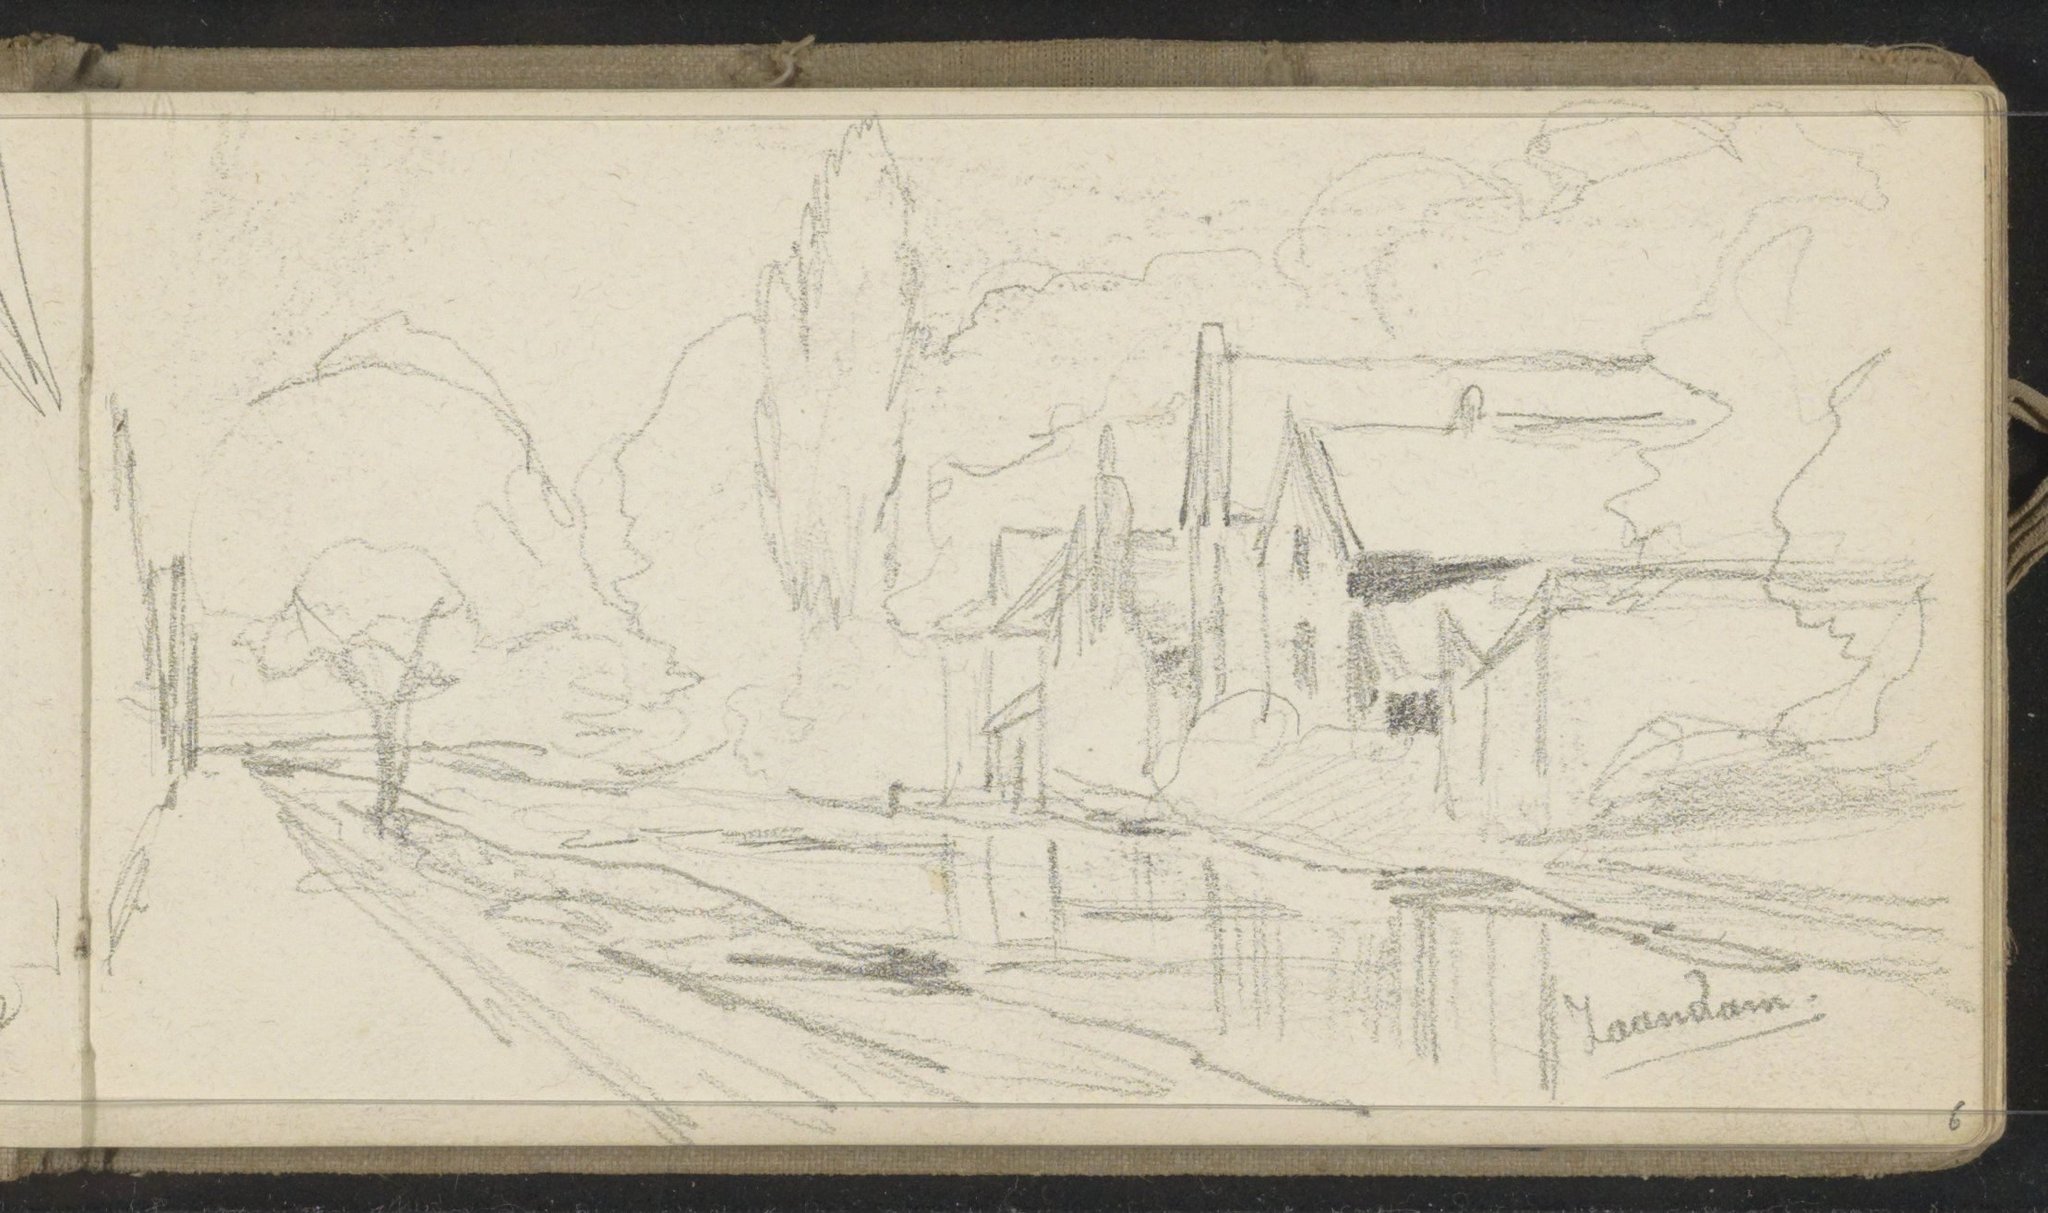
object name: sketchbook leaf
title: Huizen aan het water te Zaandam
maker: willem cornelis rip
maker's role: draughtsman, painter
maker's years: 1856-1922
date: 1895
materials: paper, pencil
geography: zaandam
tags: landscapes with waters, waterscapes, seascapes (in the temperate zone), the usual house or row of houses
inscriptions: annotation: ‘Zaandam’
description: Blad 6 recto uit een schetsboek met 39 bladen.